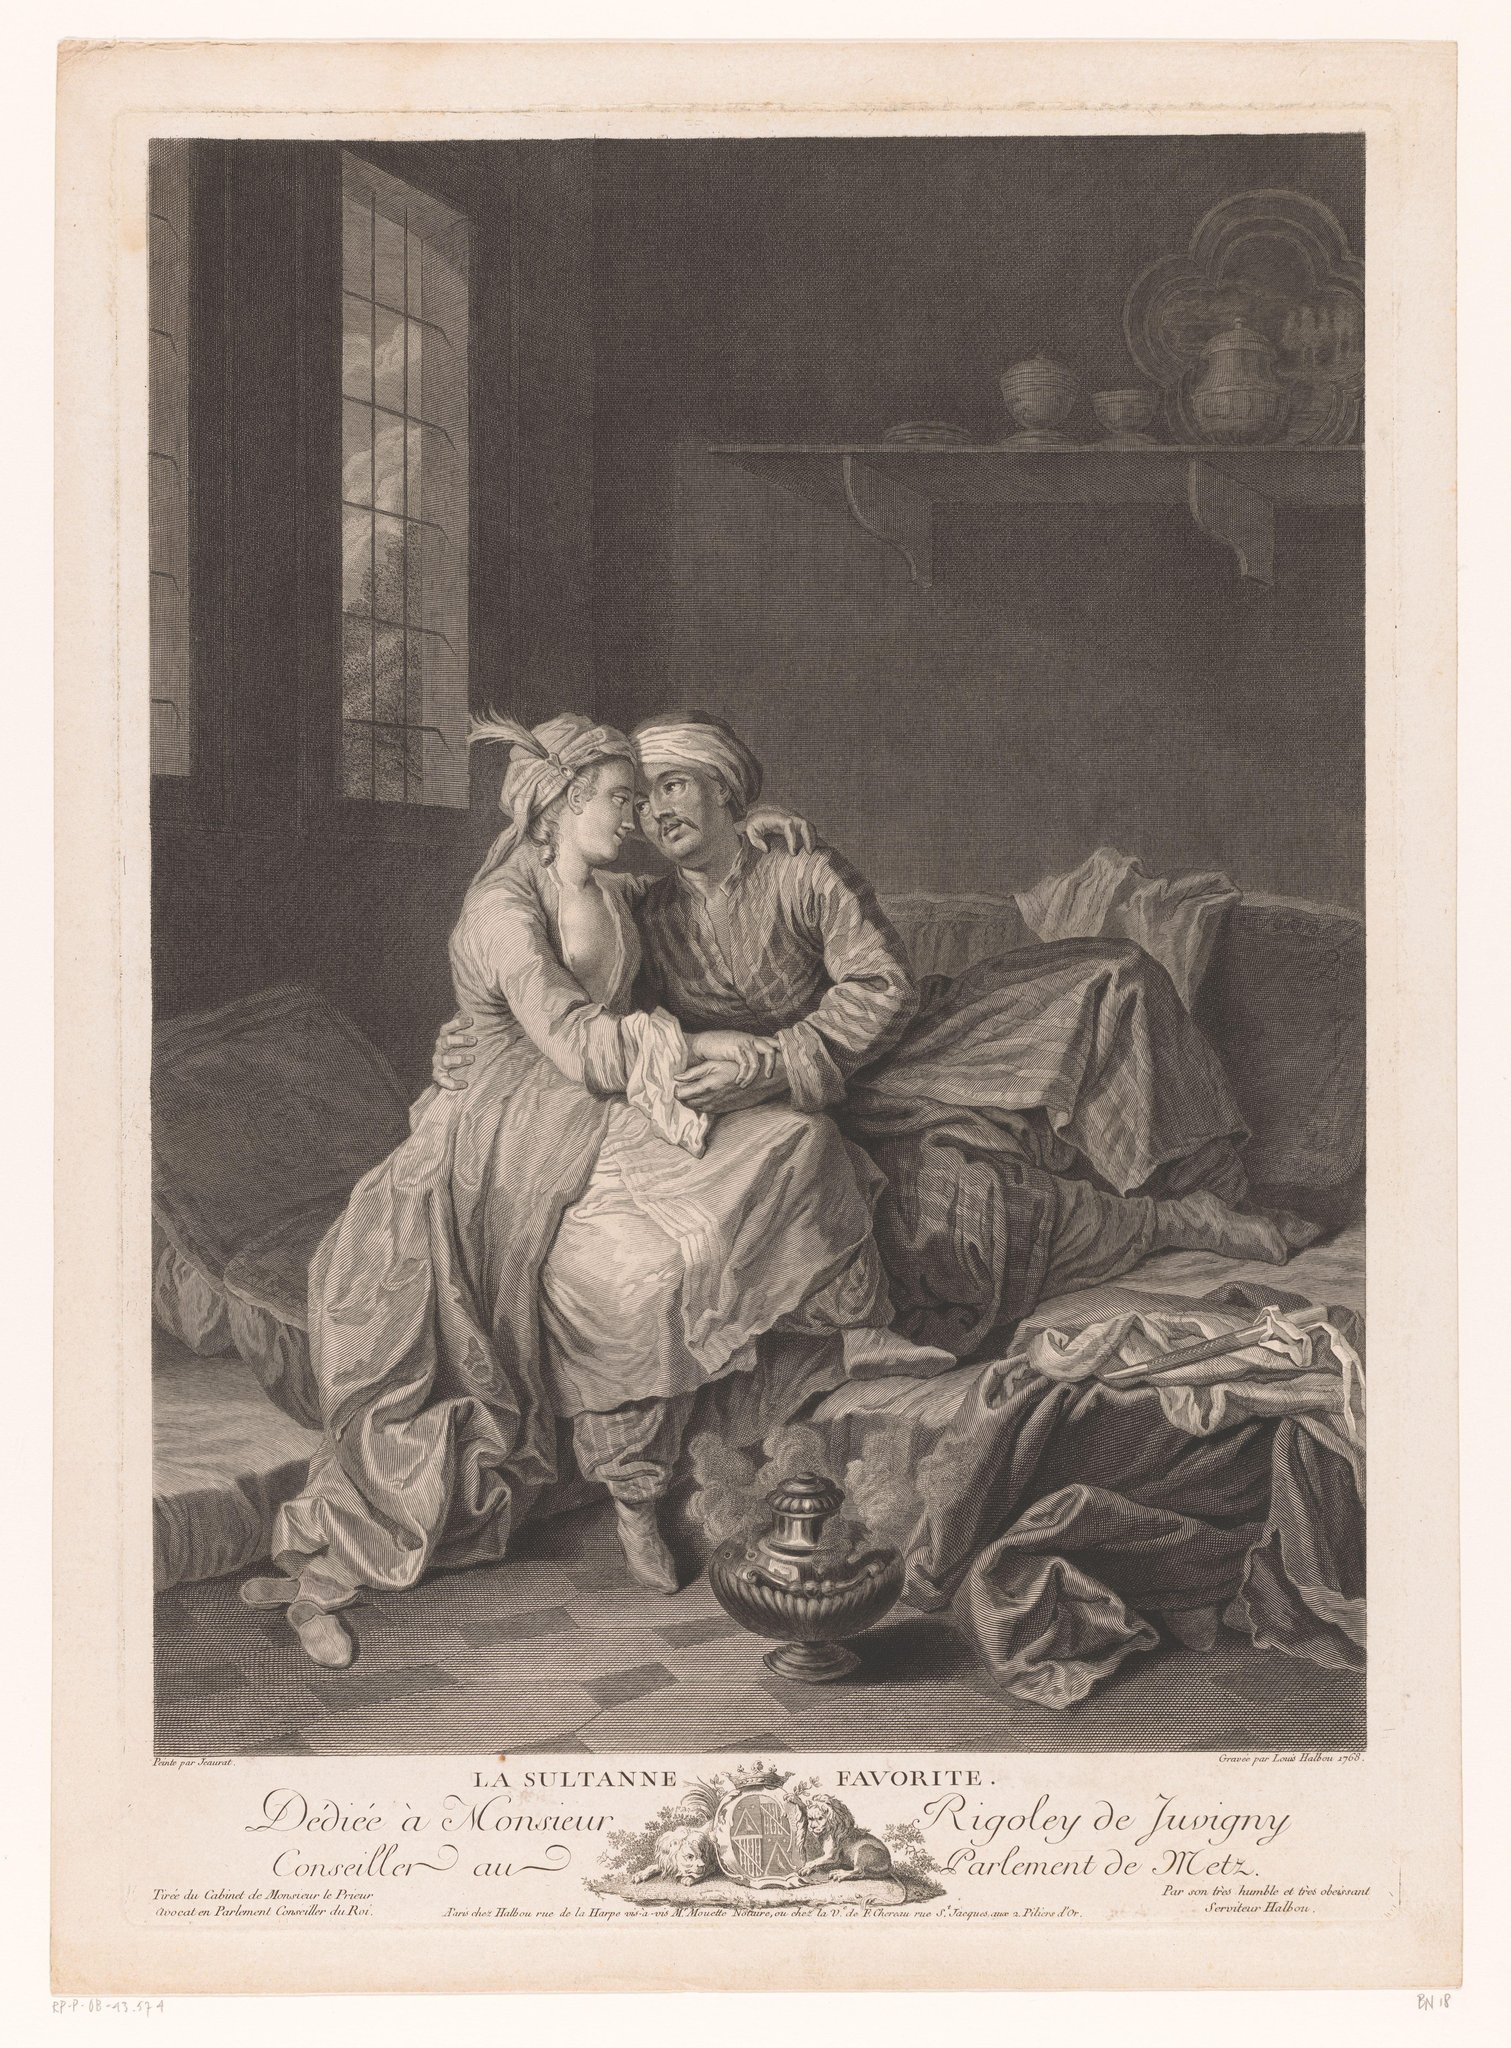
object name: print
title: Twee geliefden in een interieur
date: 1768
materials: paper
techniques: engraving, etching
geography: france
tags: breasts, asiatic races and peoples: turks, head-gear: turban, lovers' meeting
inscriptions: collector's mark: Lugt 2228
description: Oosters interieur met een vrouw met ontblote borst naast een sultan.